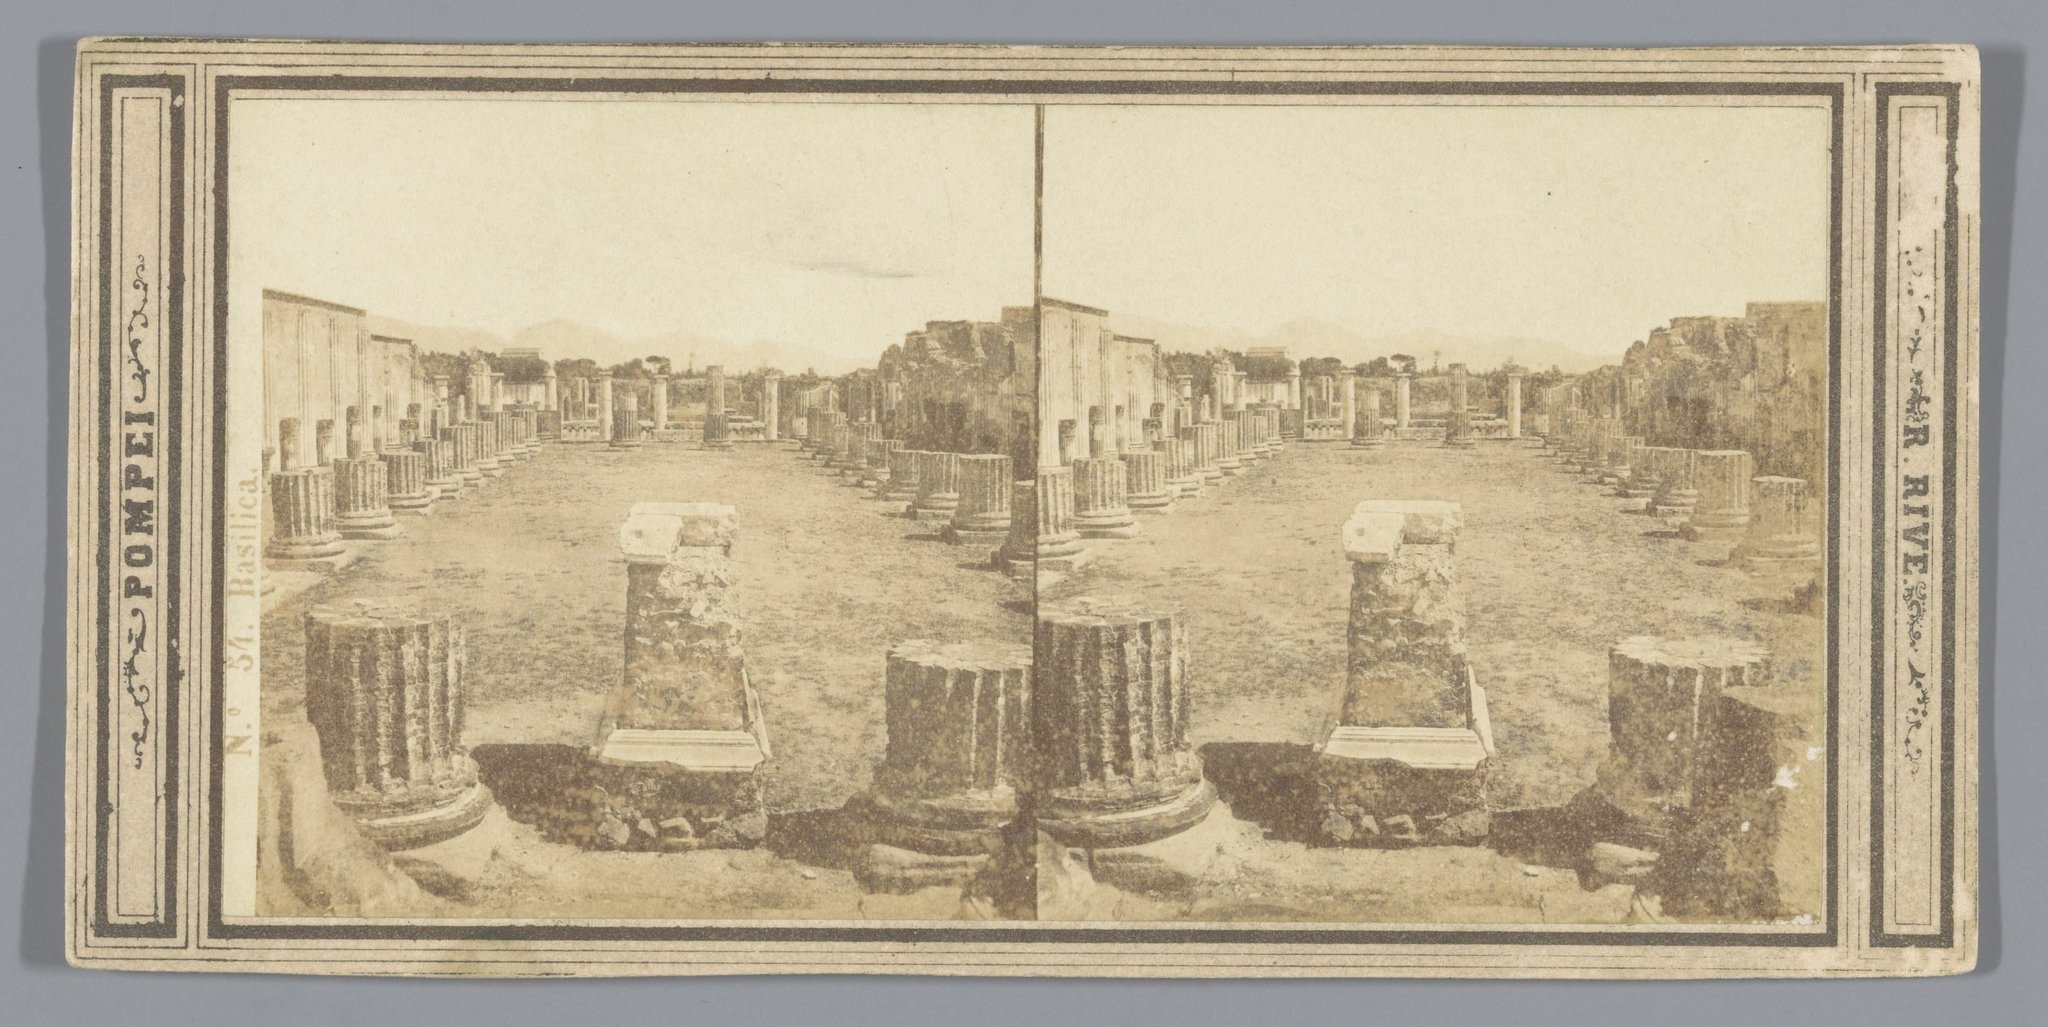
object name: stereograph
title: Pompei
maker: roberto rive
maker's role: fotograaf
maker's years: 1825-1868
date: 1860-1880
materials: cardboard, photographic support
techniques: albumen print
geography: pompeii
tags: ruin of church, monastery, etc.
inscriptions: inscription: ‘L. 11’, number: ‘No. 54.’